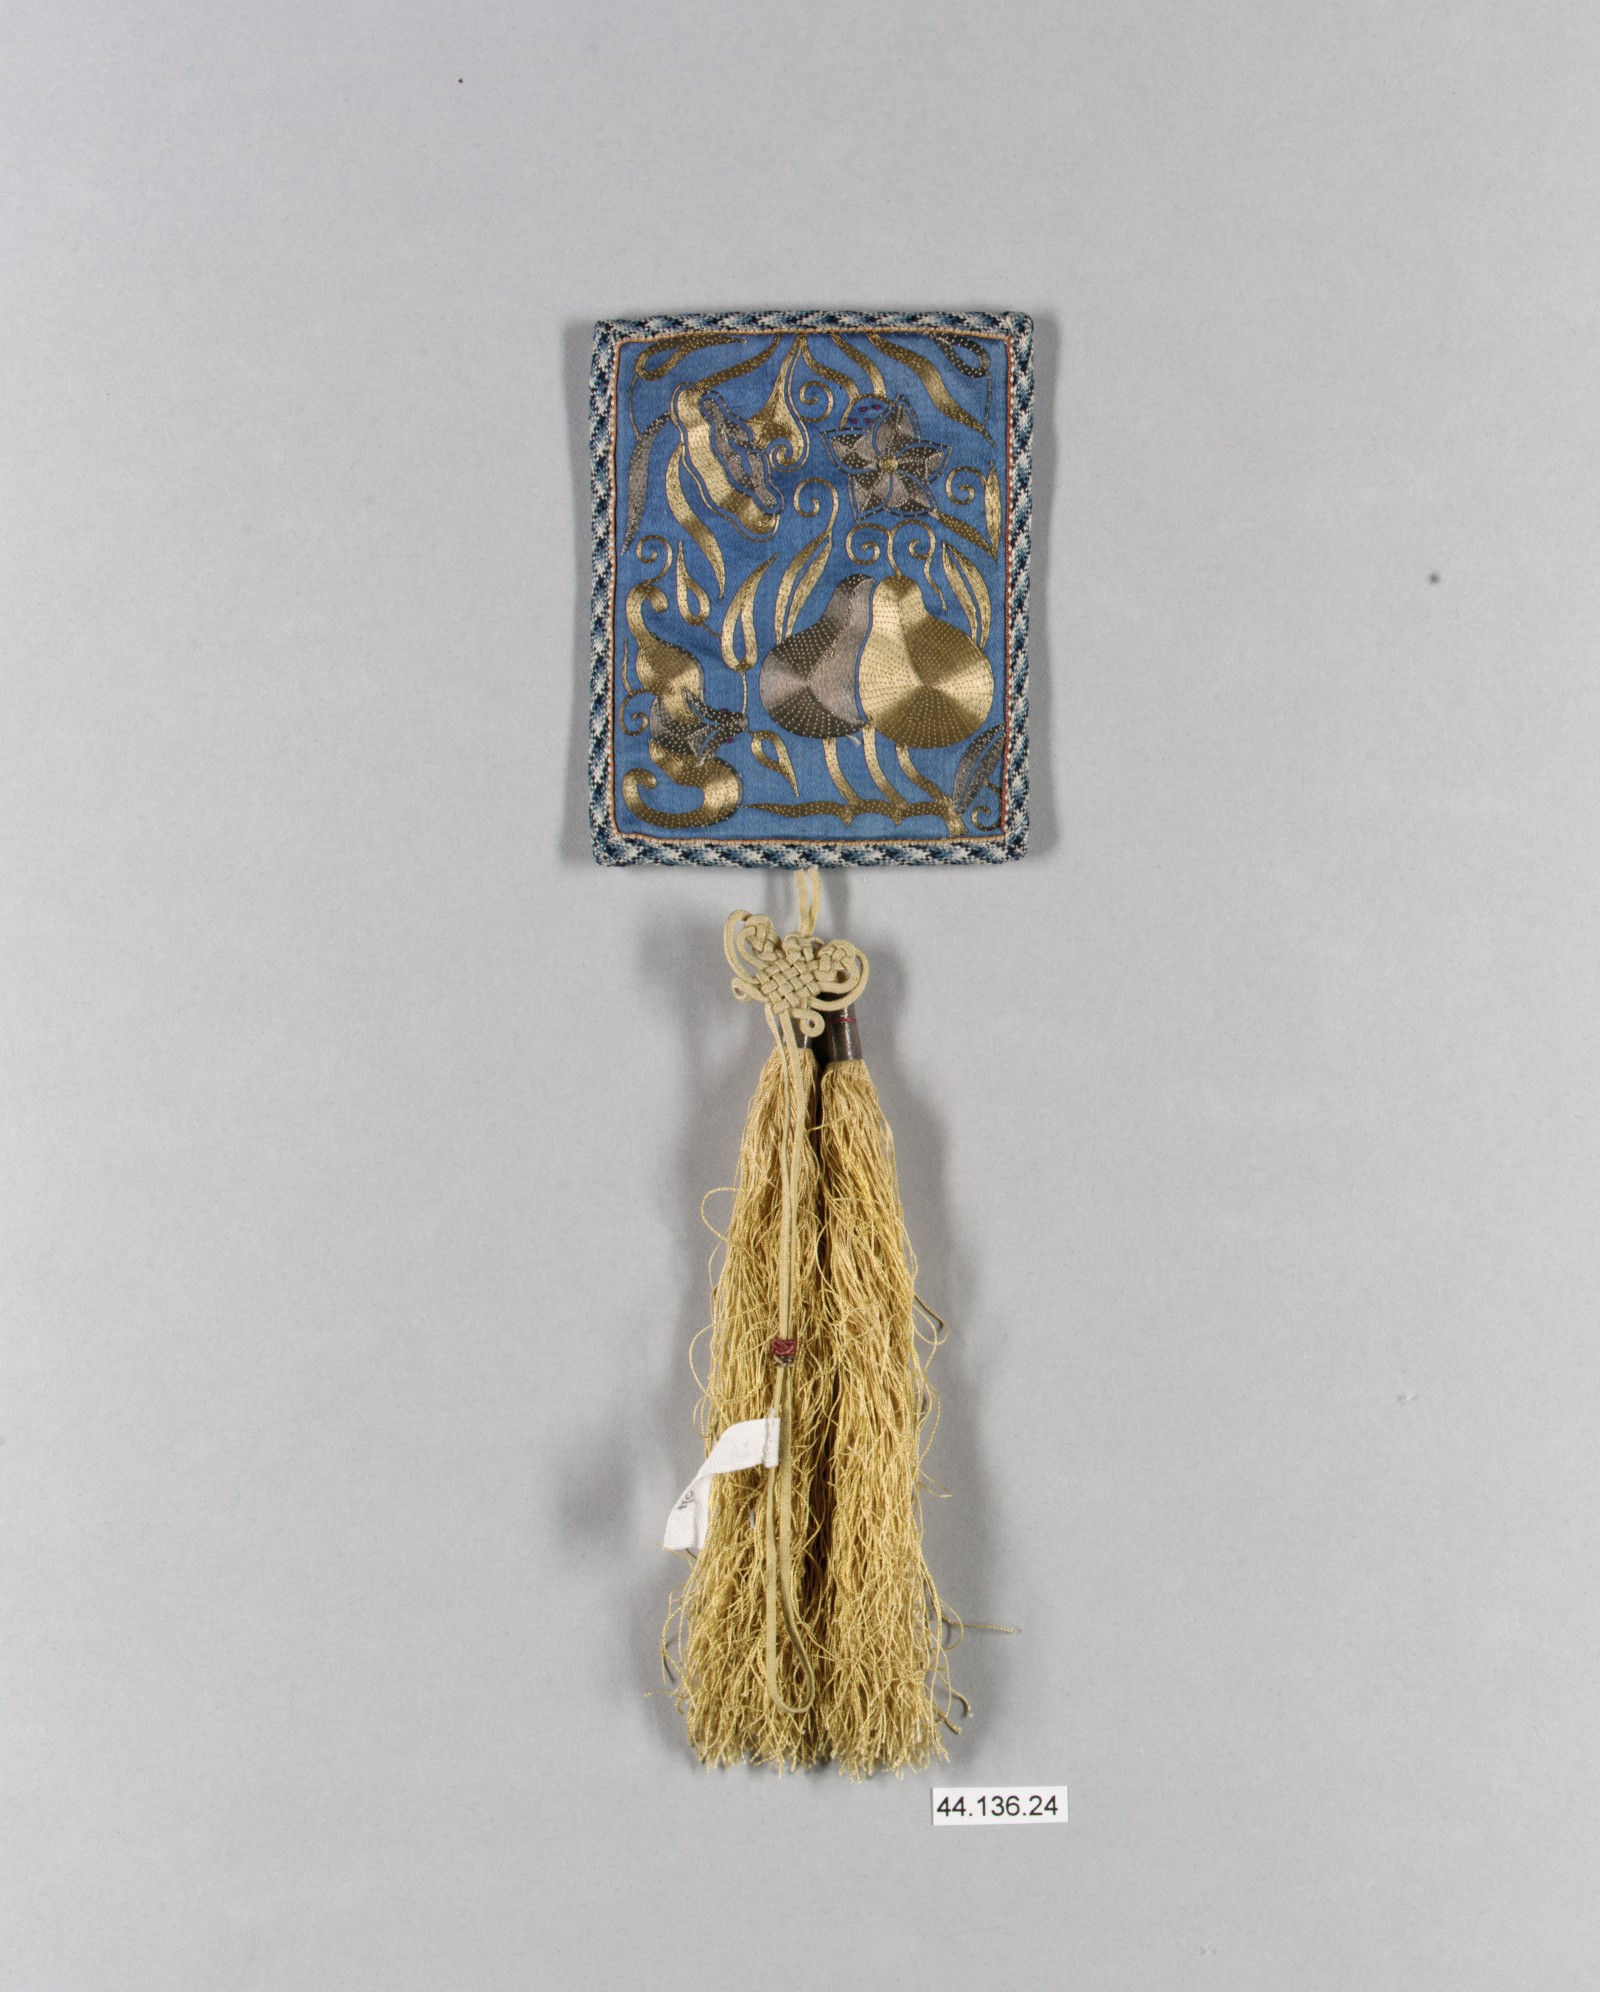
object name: mirror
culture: chinese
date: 1801-1900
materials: glass, metal thread, silk